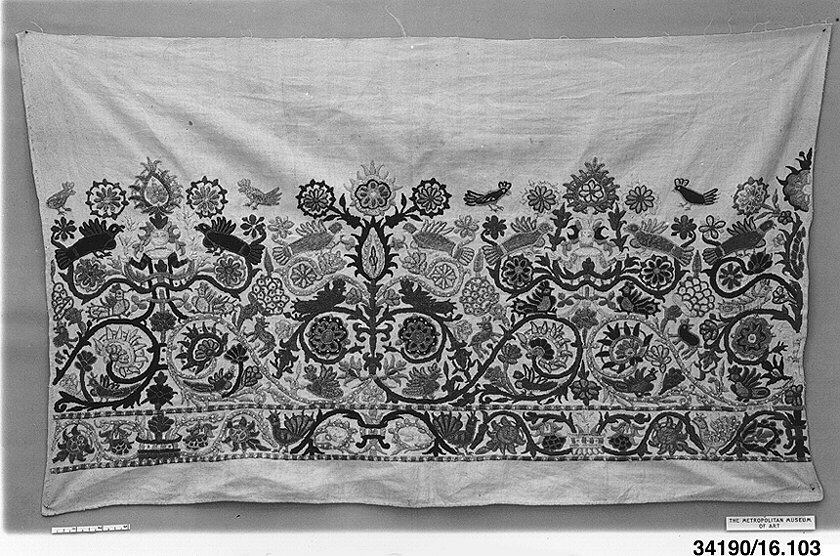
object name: border fragment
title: Part of a dress border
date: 1701-1800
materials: linen, silk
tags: birds,flowers